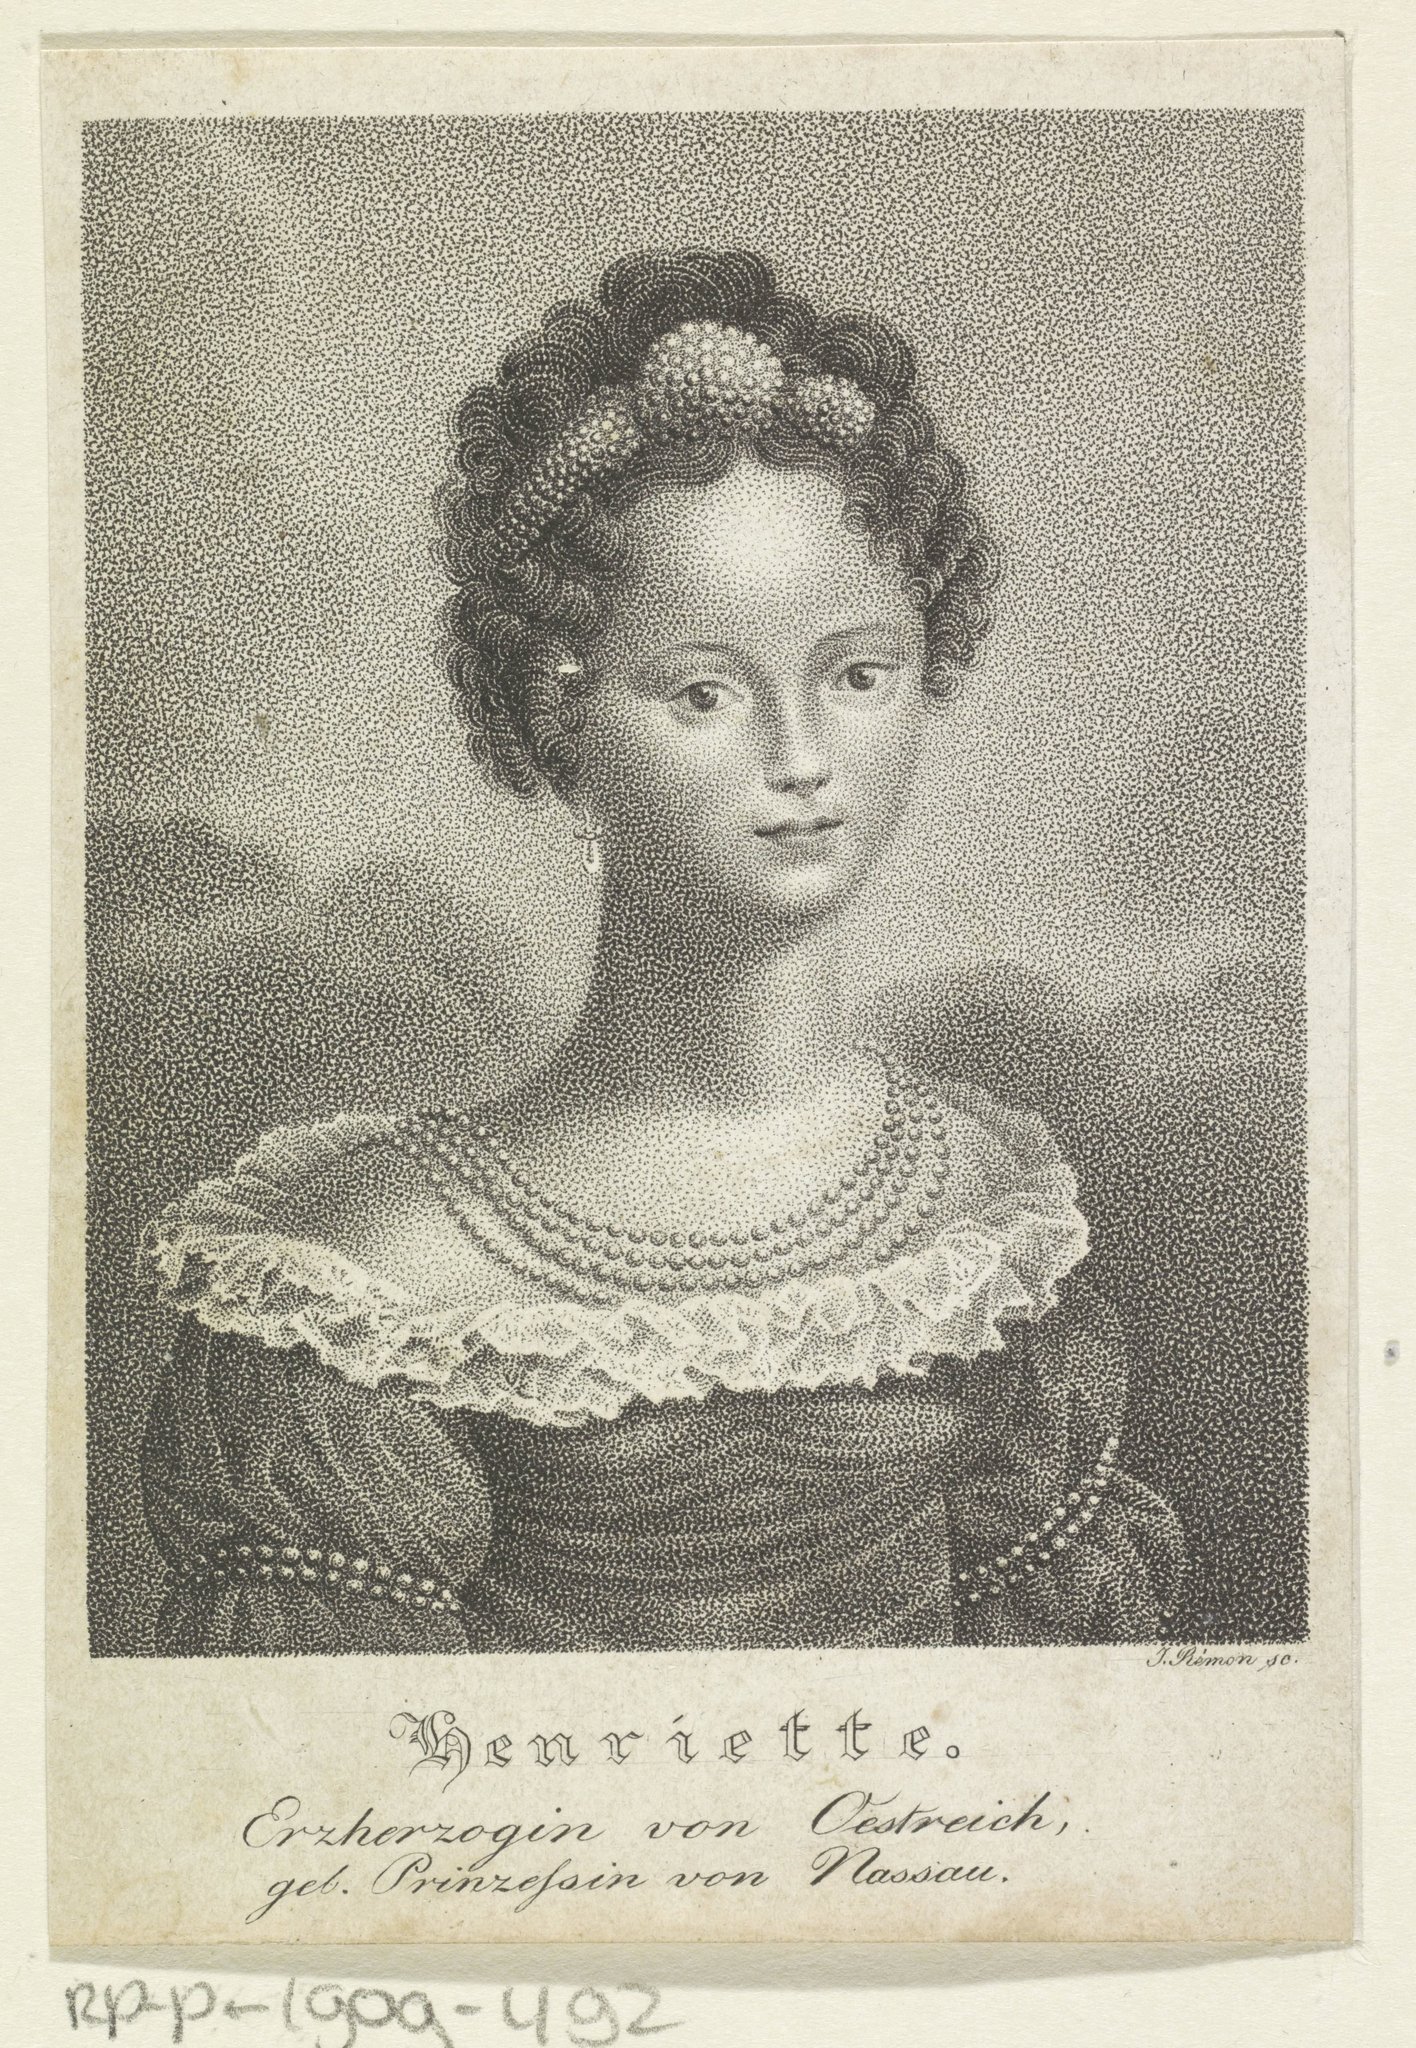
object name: print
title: Portret van Henriëtte van Nassau-Weilburg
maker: j. rémon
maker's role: print maker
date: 1815-1899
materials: paper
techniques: engraving, etching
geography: germany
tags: vienna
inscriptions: collector's mark: Lugt 2228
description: Portret van Henriëtte. In de ondermarge haar naam en titels.